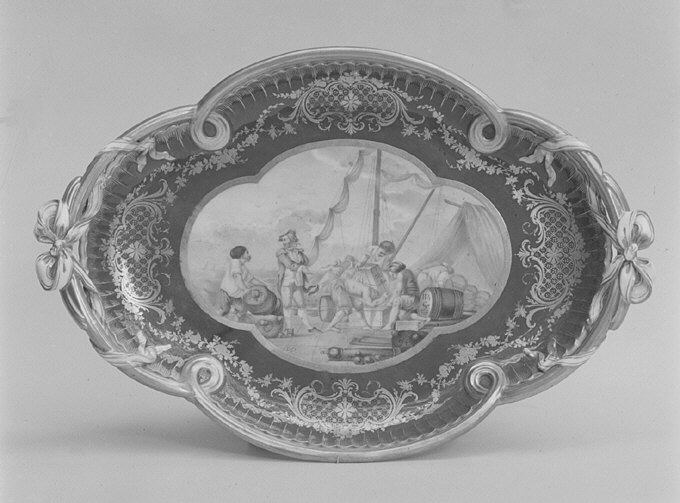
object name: tray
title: Tray (part of a service)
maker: sèvres manufactory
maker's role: manufactory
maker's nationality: french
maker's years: 1740-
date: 1775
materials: soft paste porcelain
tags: men,boats